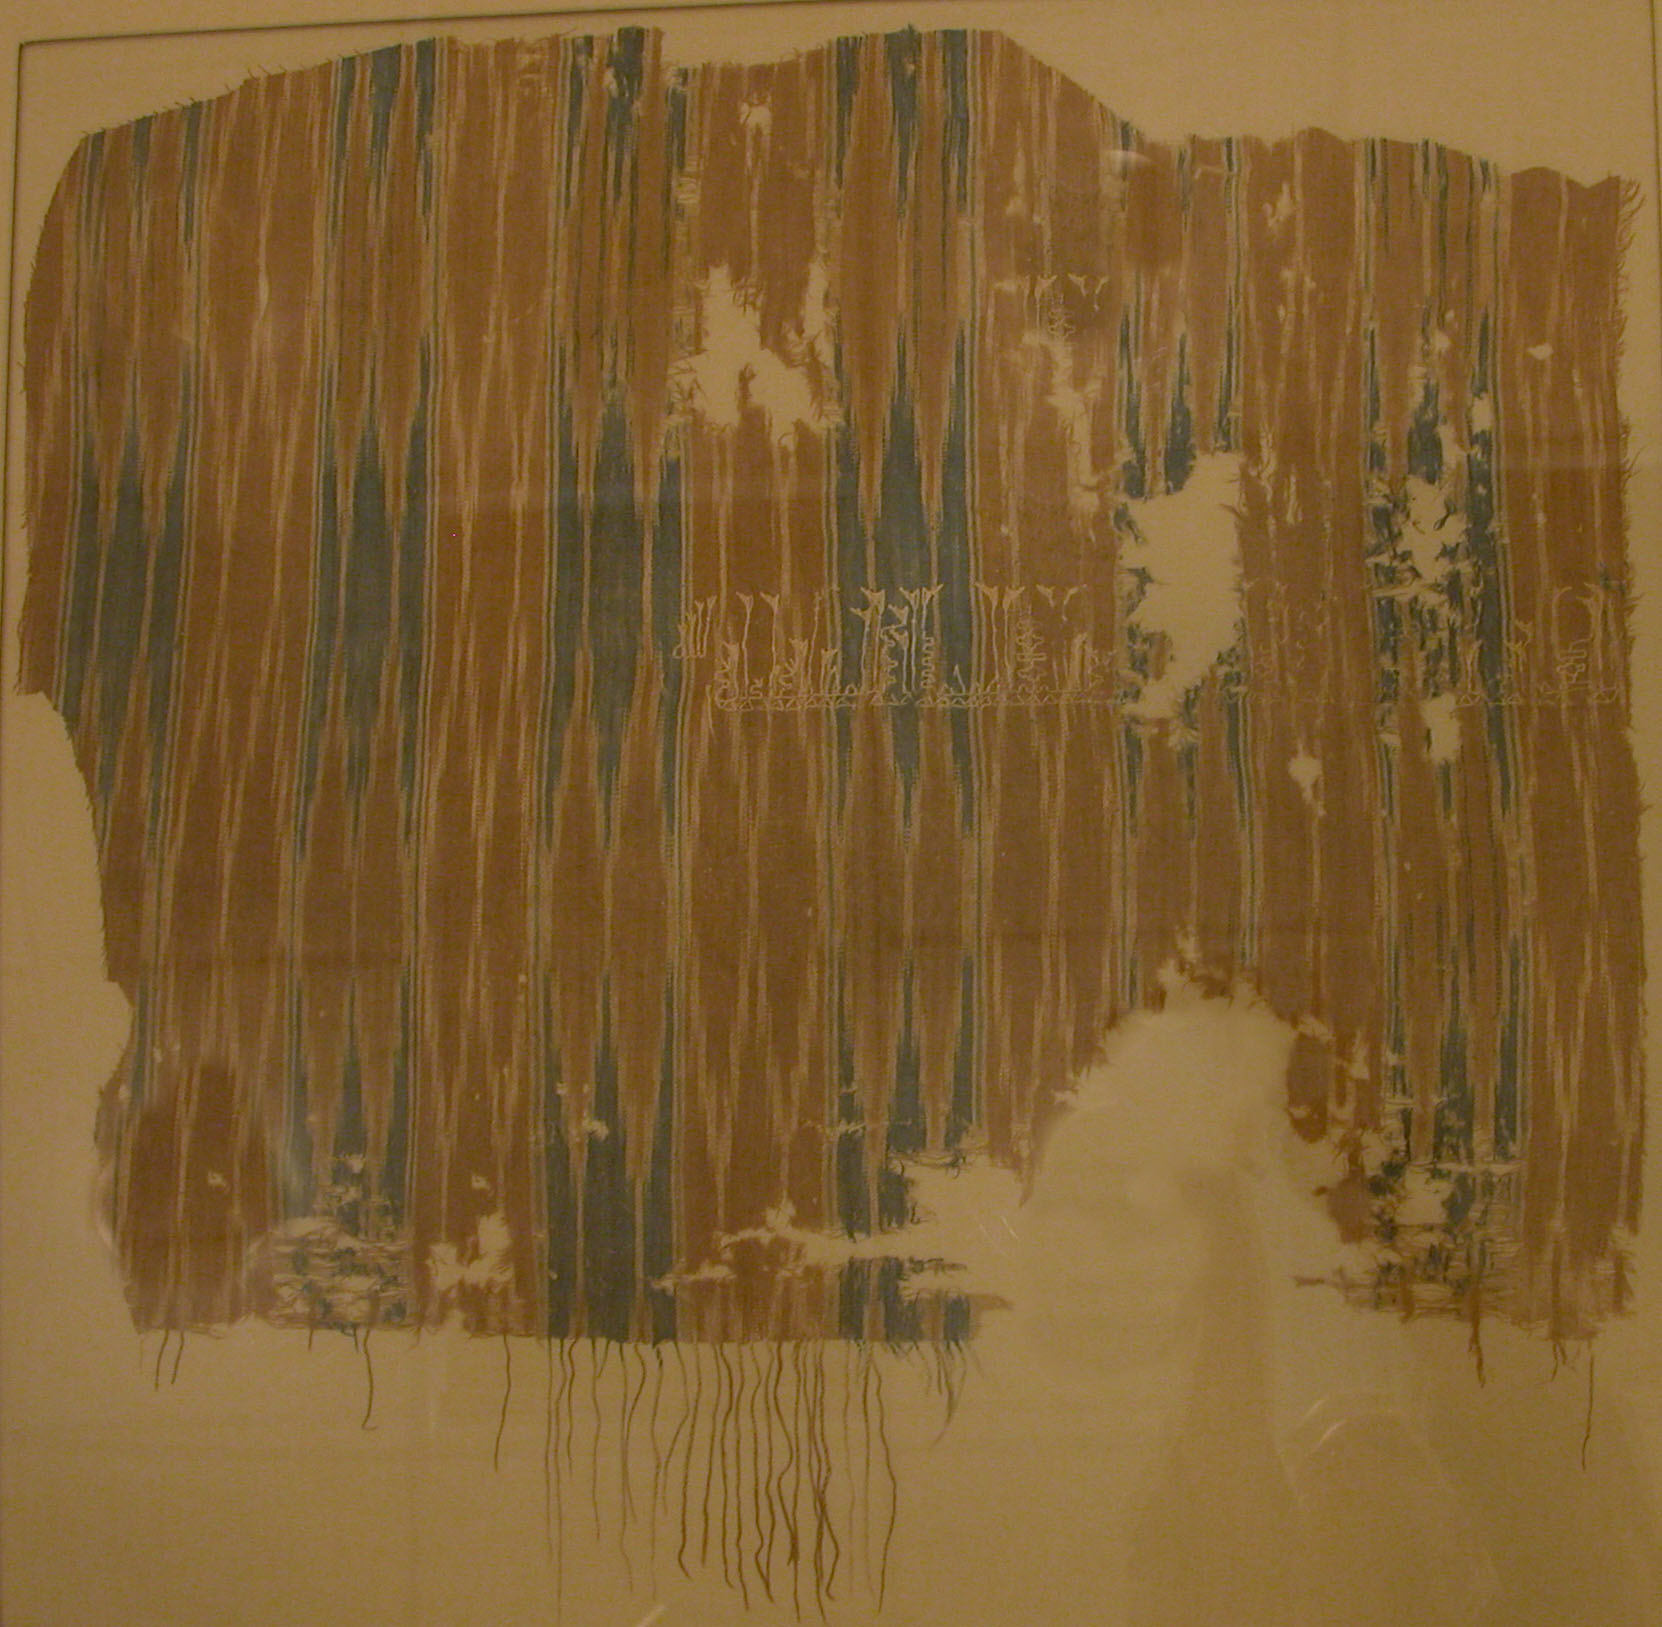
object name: textile fragment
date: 901-1000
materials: cotton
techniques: dyeing, embroidery, weave, resist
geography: yemen